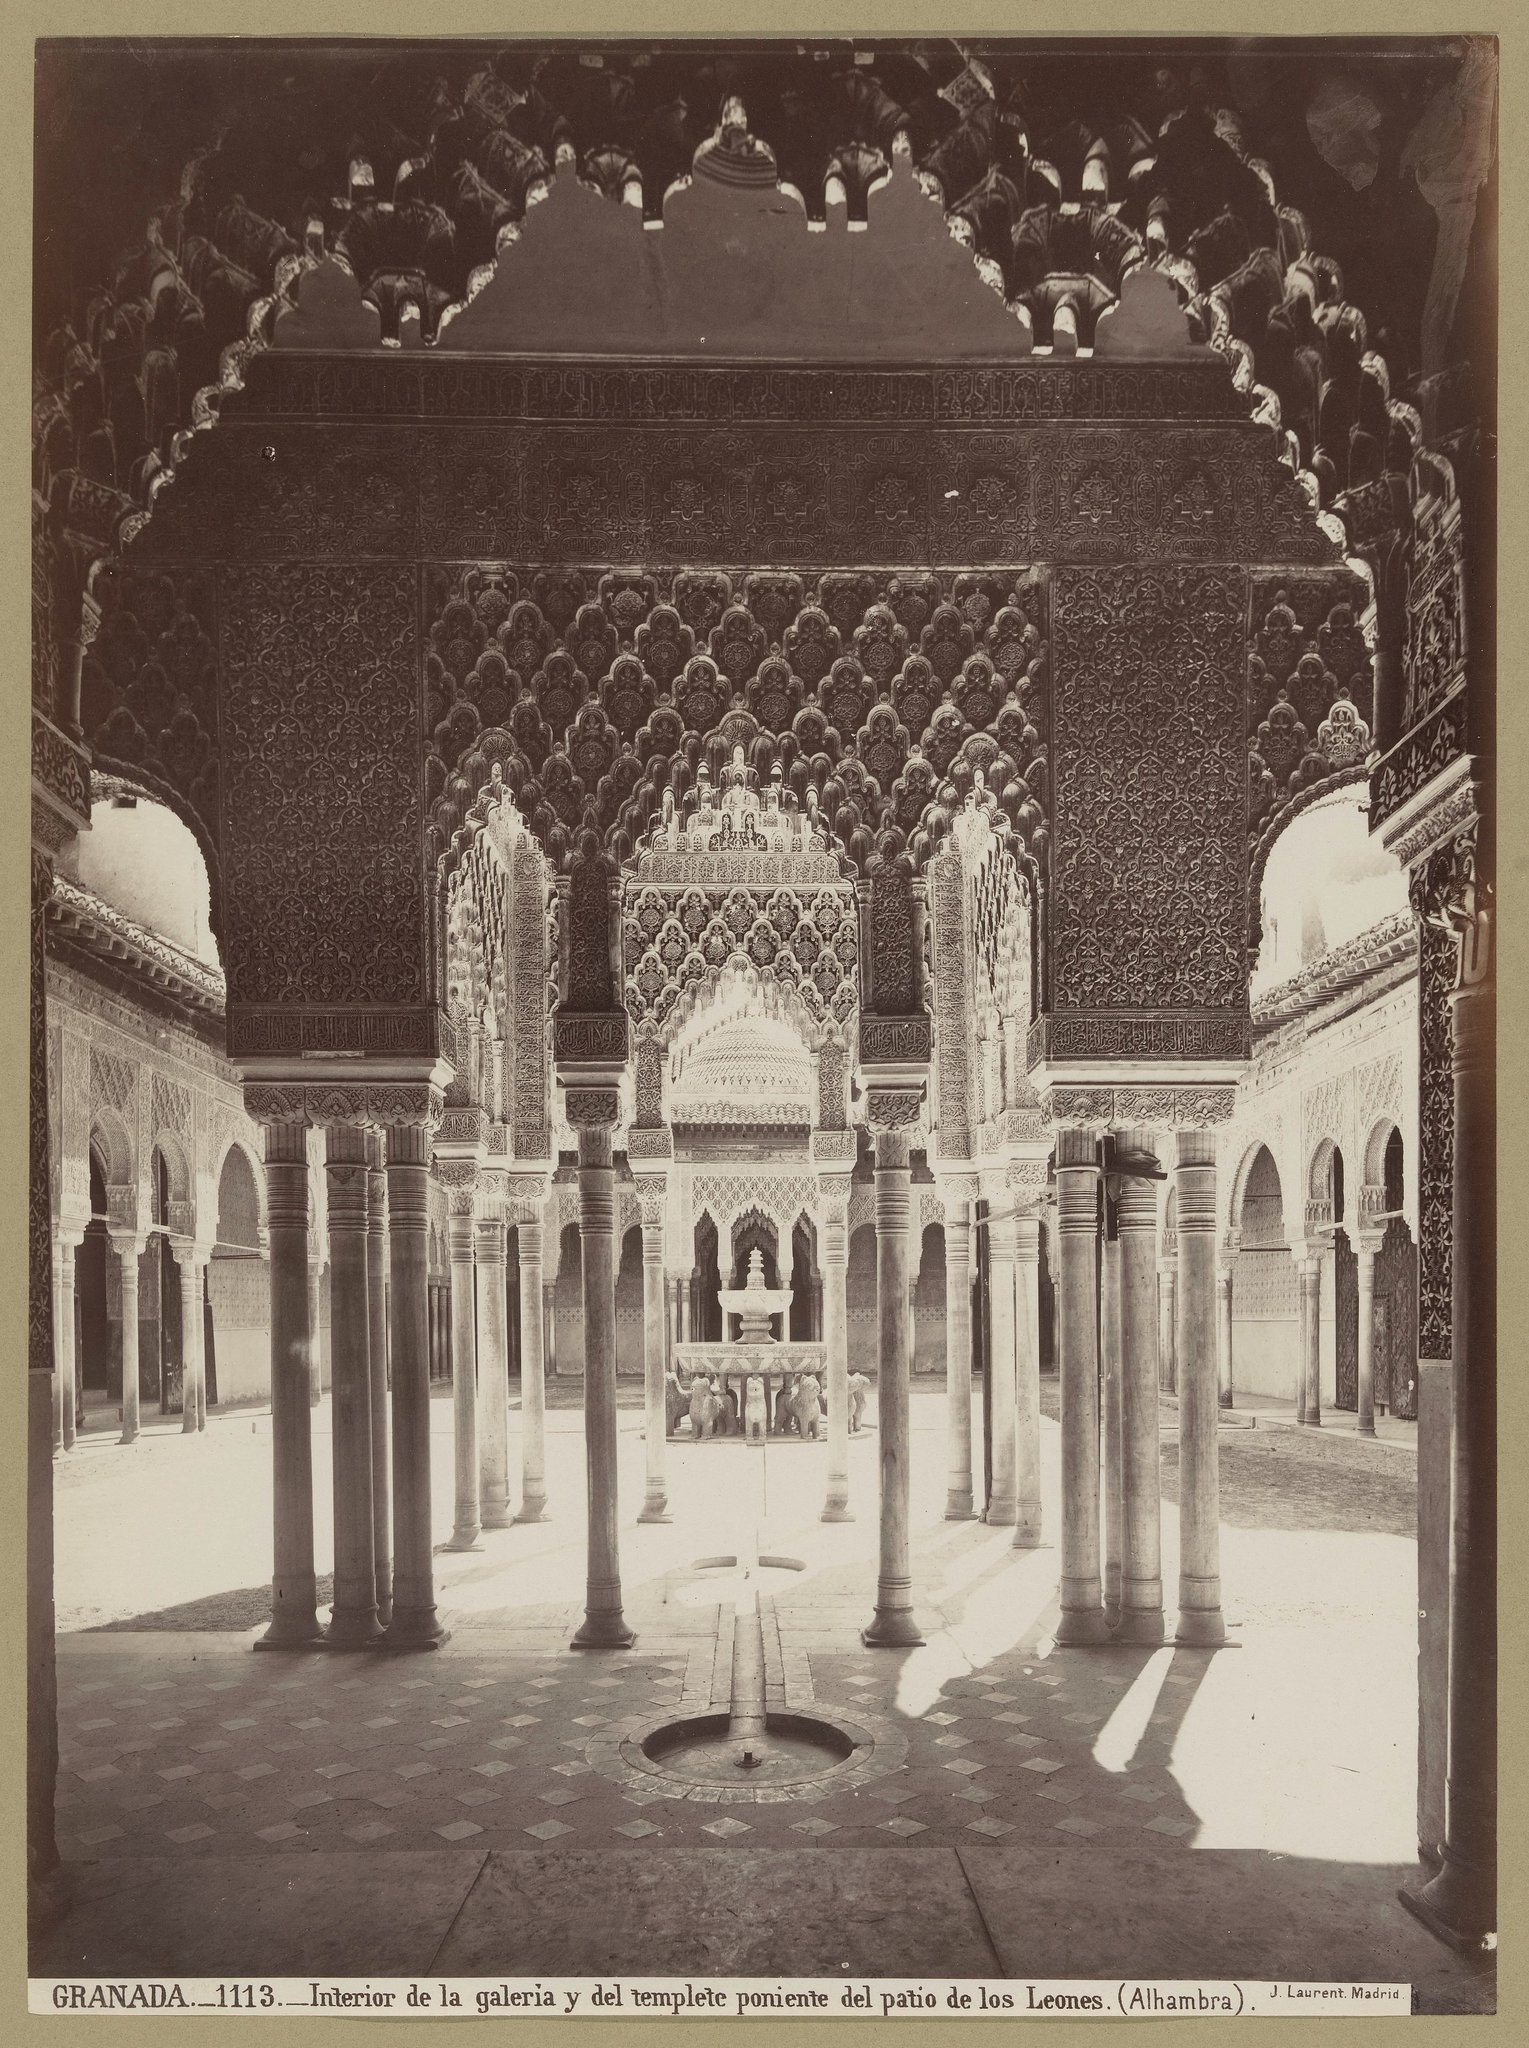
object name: photograph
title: Granada, interior de la galeria y del templete poniente del patio de los Leones (Alhambra)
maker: juan laurent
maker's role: publisher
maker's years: 1816-1896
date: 1856-1863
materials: paper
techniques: albumen print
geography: granada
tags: courtyard, ornamental fountain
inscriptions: number: ‘1113.’